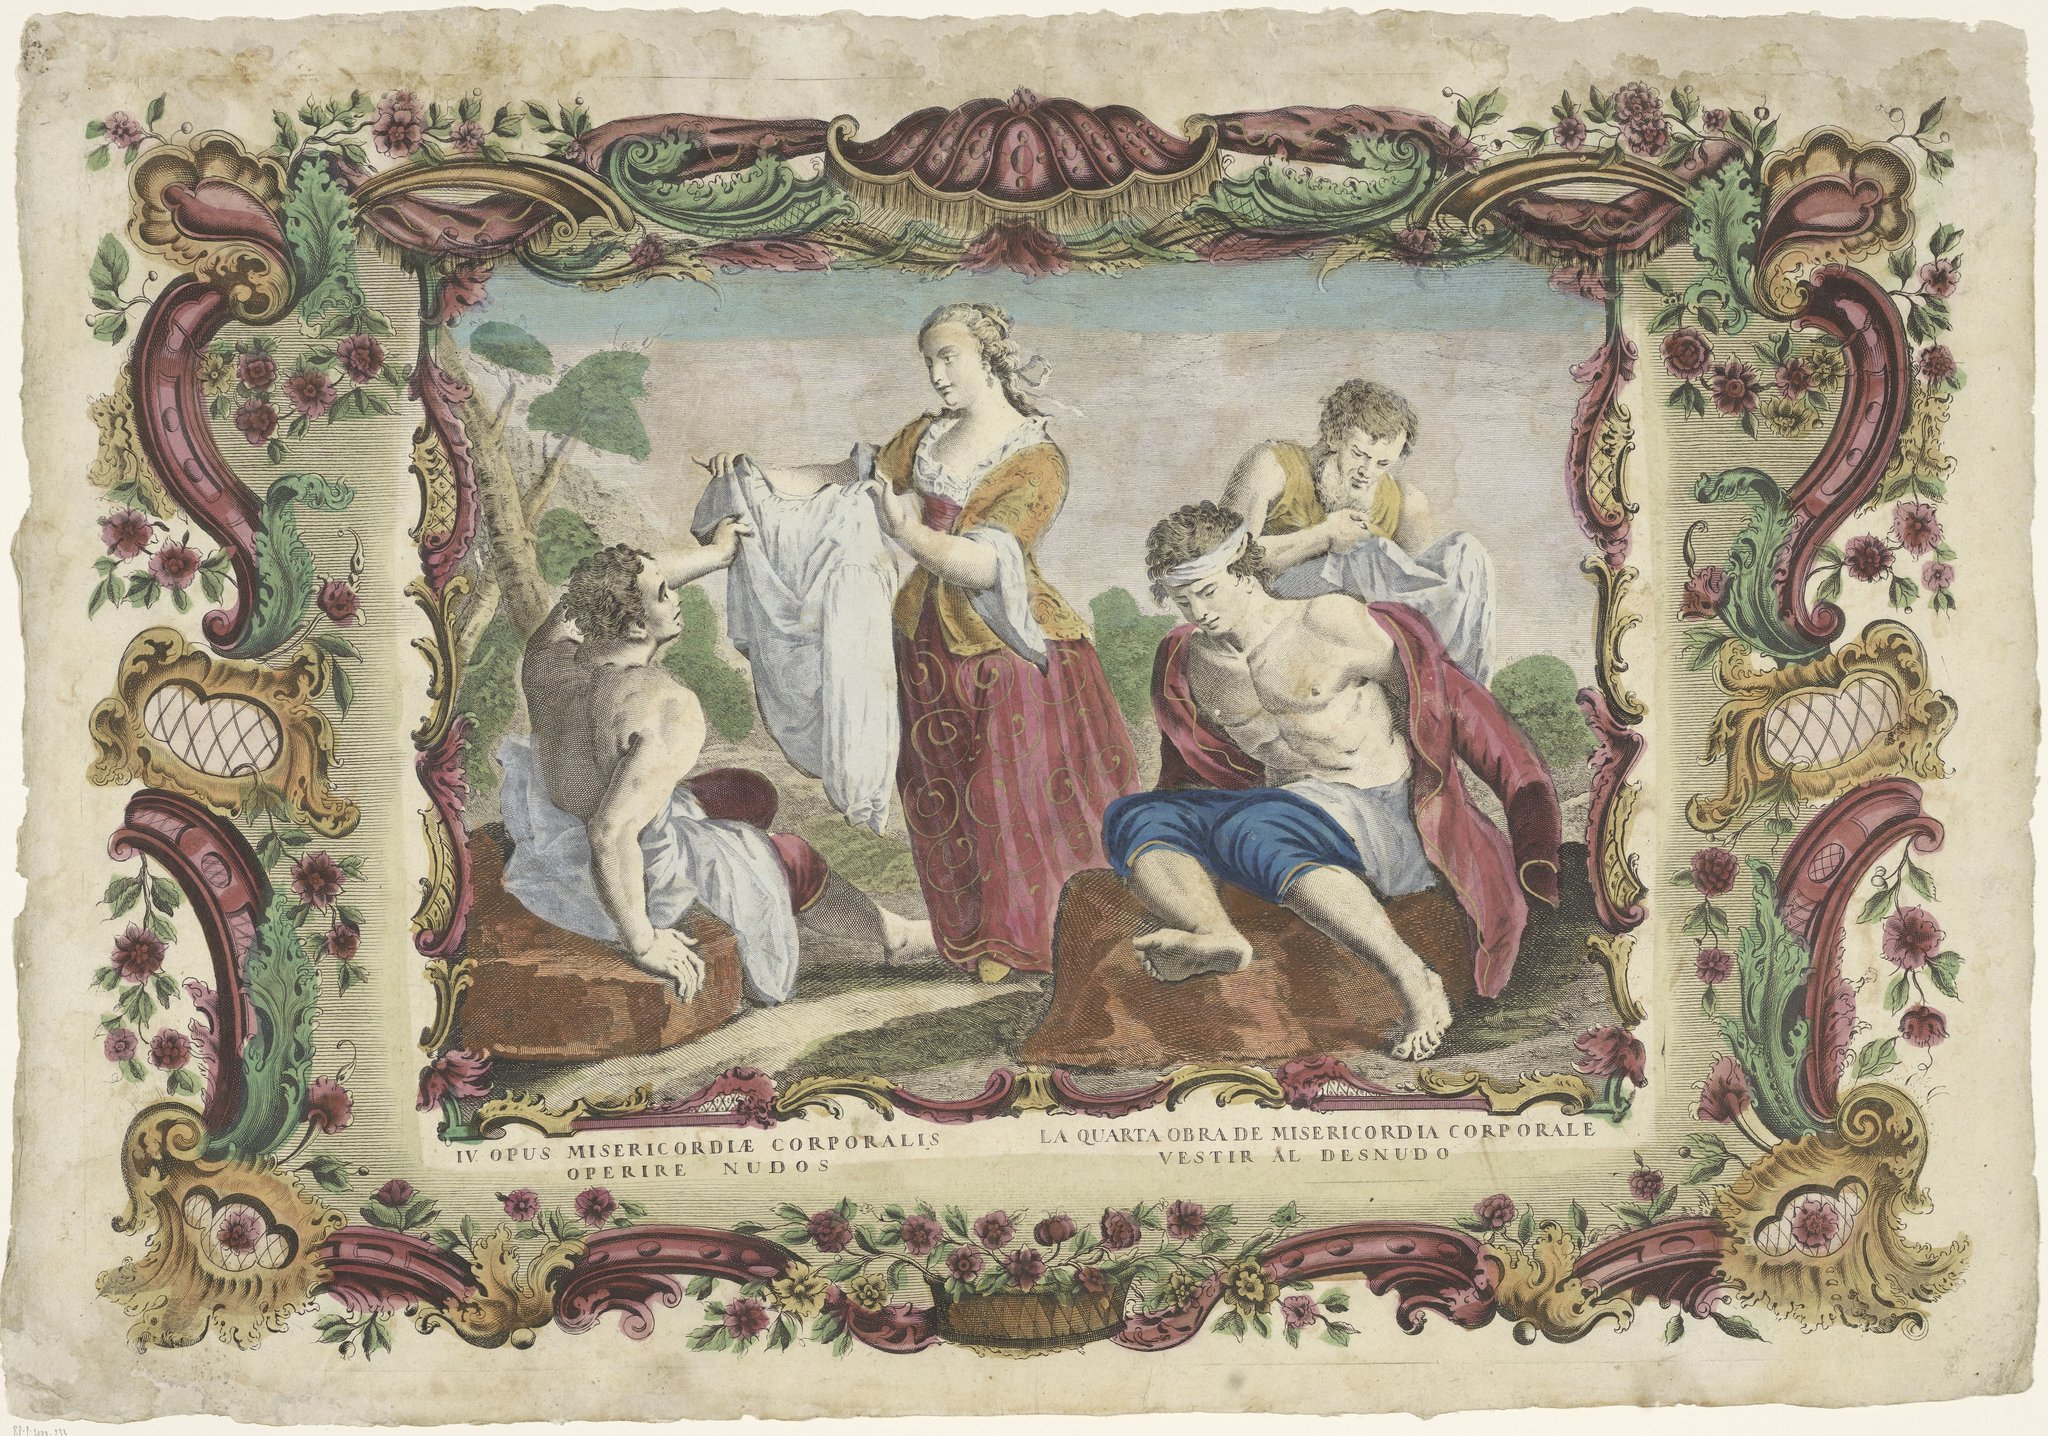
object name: print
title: De naakten kleden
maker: giovanni volpato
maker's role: ceramicist, print maker, printer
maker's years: 1735-1803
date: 1700-1799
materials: paper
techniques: colour, engraving, etching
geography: bassano del grappa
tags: ornaments ~ art, clothing the naked, 'nudus vestitur' ~ one of the (seven) acts of mercy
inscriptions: collector's mark: Lugt 2760, collector's mark: Lugt 2228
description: Uitbeelding van één van de werken van barmhartigheid: het kleeden van de naakten. Twee jongemannen, van wie een een verband om zijn hoofd heeft, worden aangekleed door een jonge vrouw en een oude man. Titel onder de voorstelling. De scène is gevat in een ornamentrand.